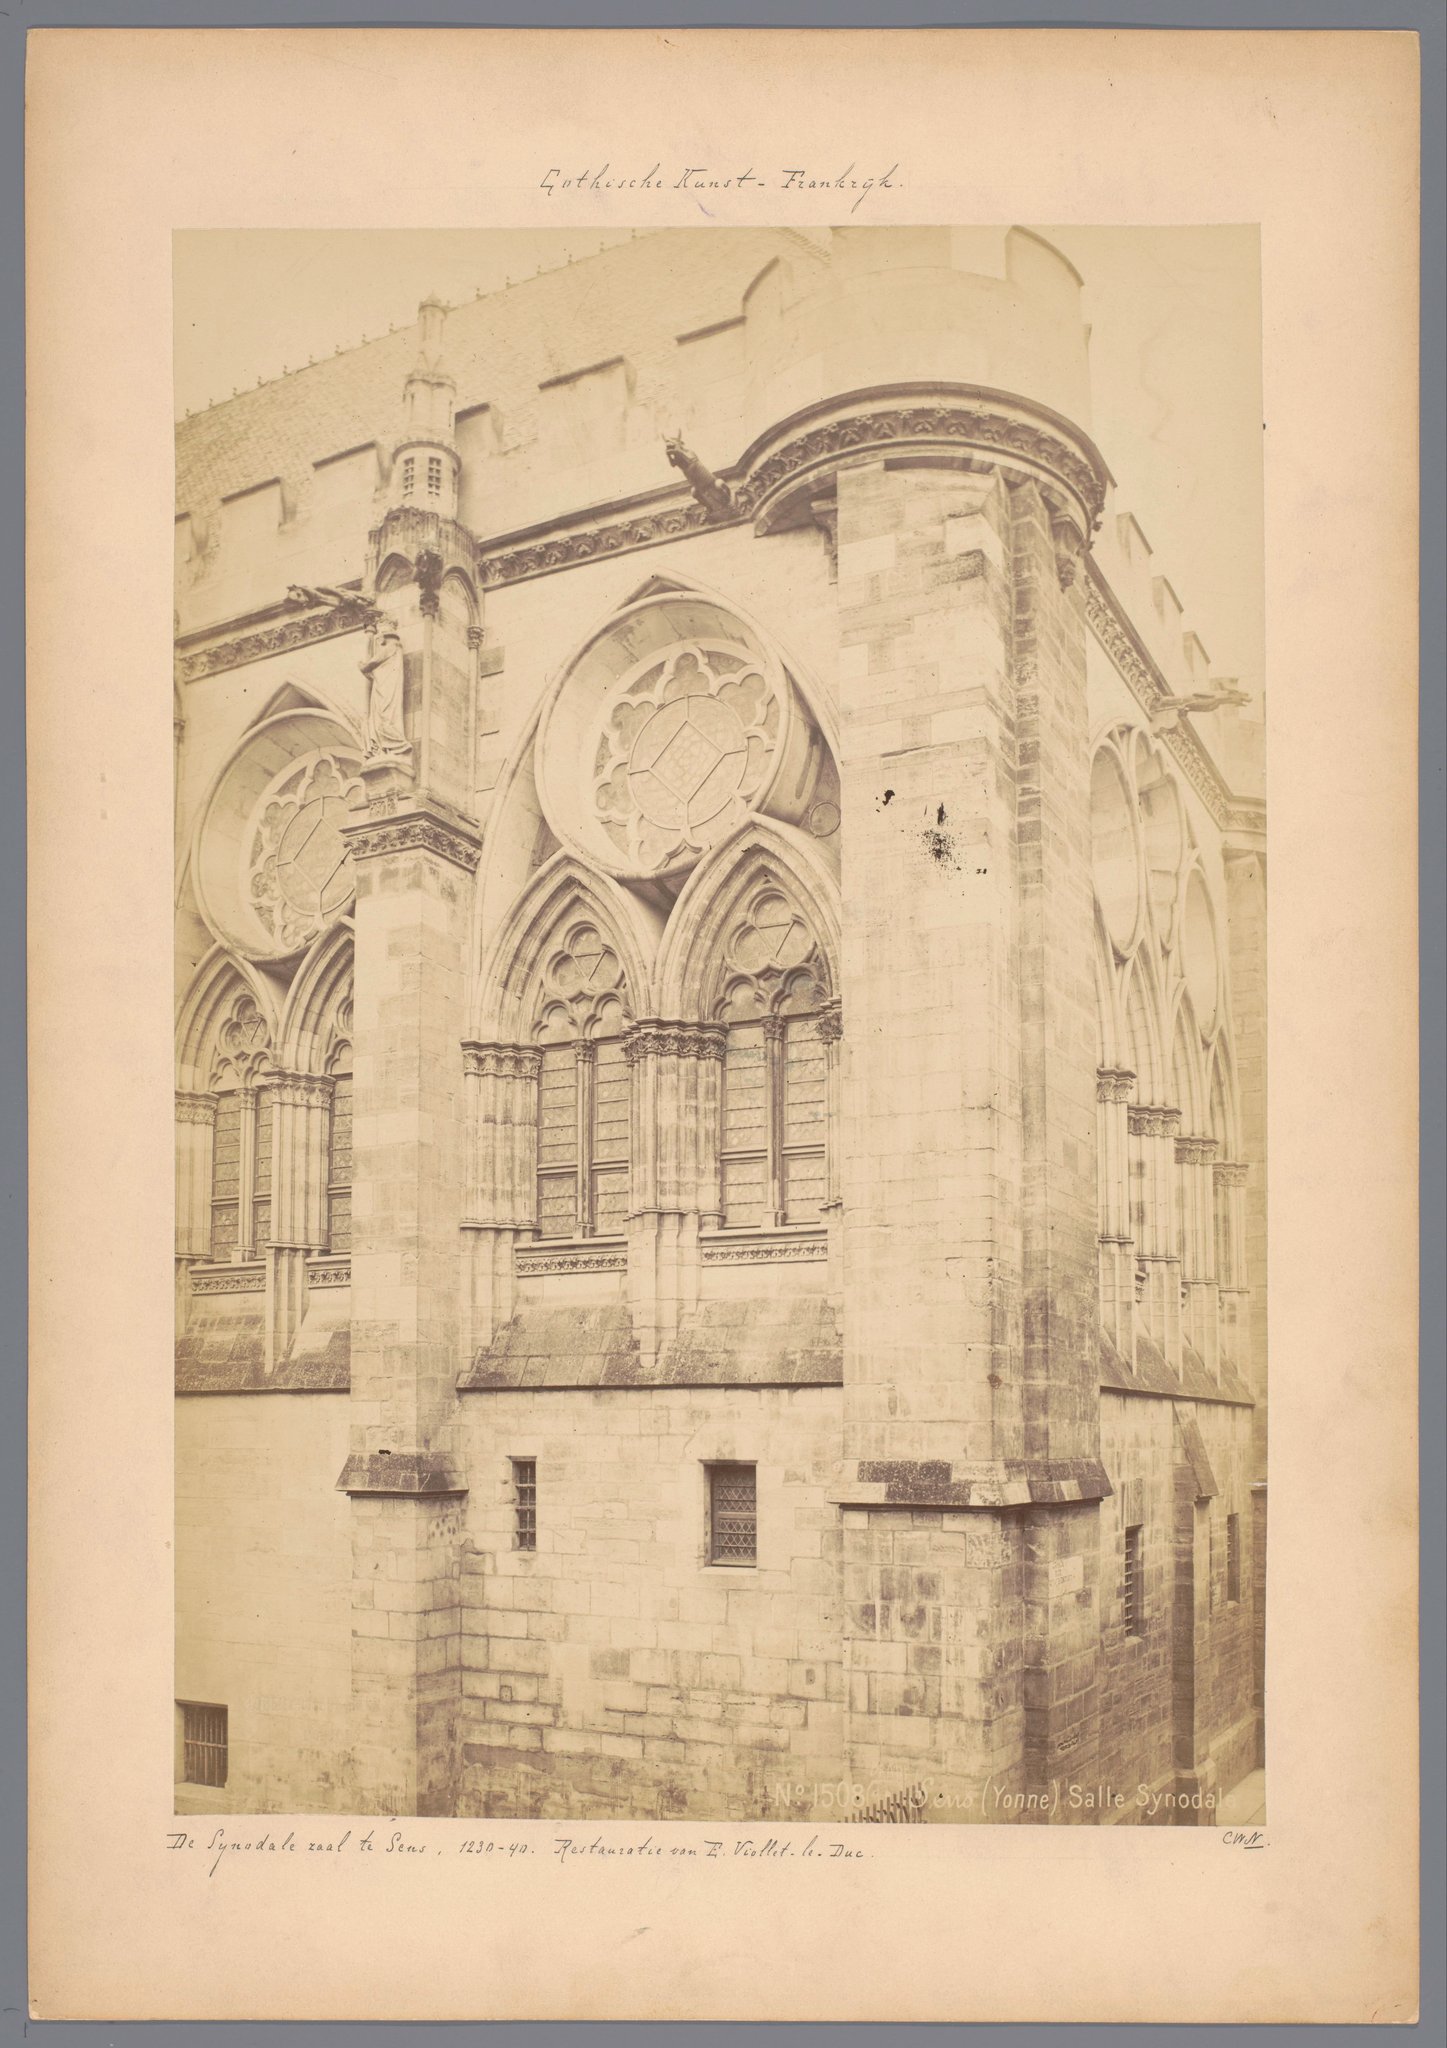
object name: photograph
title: Deel van de gevel van het synodaal Paleis te Sens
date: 1875-1900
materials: cardboard, photographic support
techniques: albumen print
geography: paris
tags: palace, façade (of house or building)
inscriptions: name: ‘ROBERT-MIEUSEMENT, Edit PARIS’, number: ‘No 1508’, collector's mark: ‘KUNSTNIJVERHEIDSCHOOL QUELLINUS AMSTERDAM FRANS HALSSTRAAT 14.’, inscription: ‘MONUMENTS HISTORIQUES’, inscription: ‘CWN.’, inscription: ‘Gothische Kunst - Frankrijk. De Synodale zaal te Sens , 1230-40. Restauratie van E. Viollet-le-Duc.’, collector's mark: ‘INSTITUUT VOOR KUNST- NIJVERHEIDSONDERWIJS GABRIËL METSUSTRAAT No. 16. AMSTERDAM’